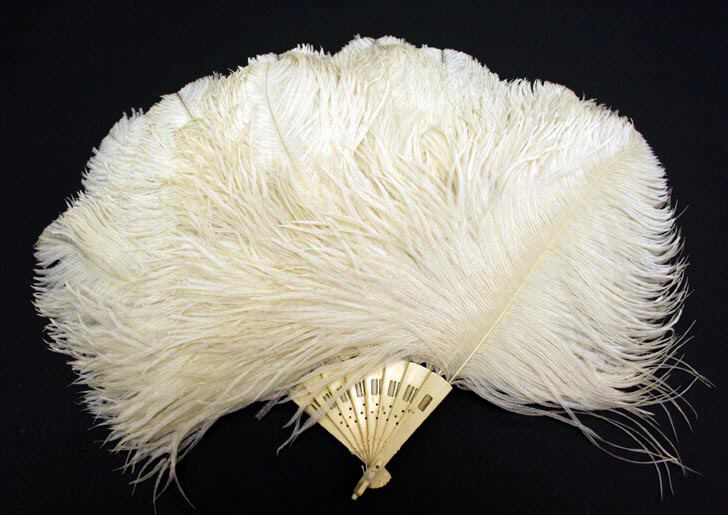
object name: fan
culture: american or european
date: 1834-1866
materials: feather, ivory